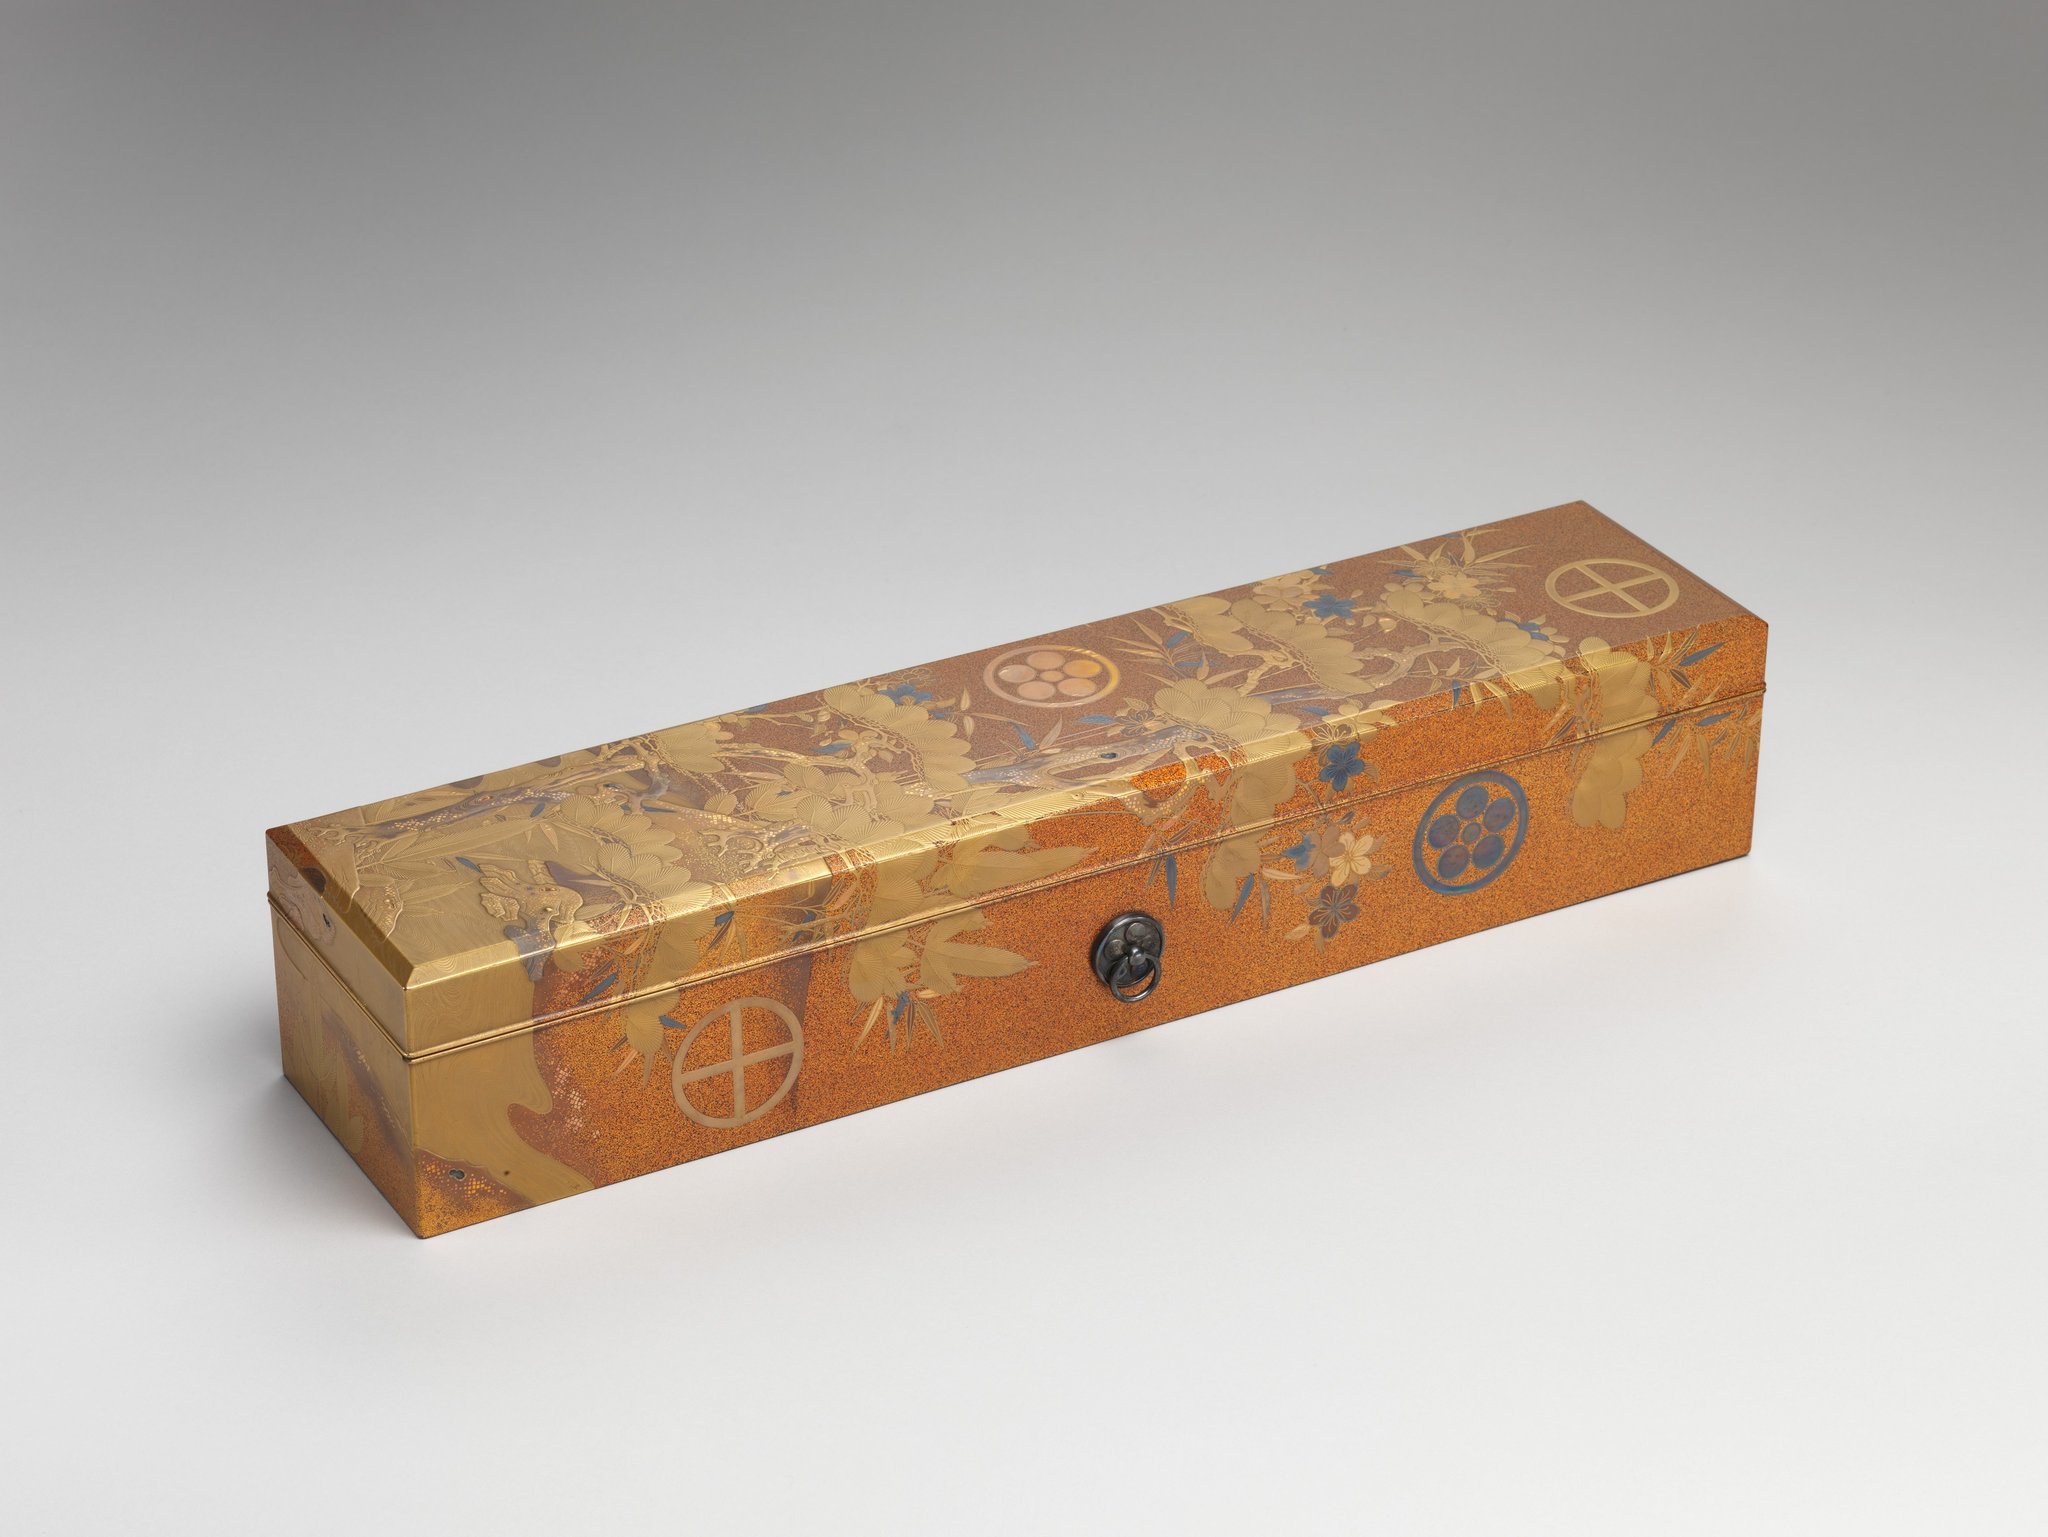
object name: dispatch box with cover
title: Box with Design of Pine, Bamboo, and Cherry Blossom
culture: japanese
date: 1801-1900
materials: gold, lacquer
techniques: maki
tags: flowers,bamboo